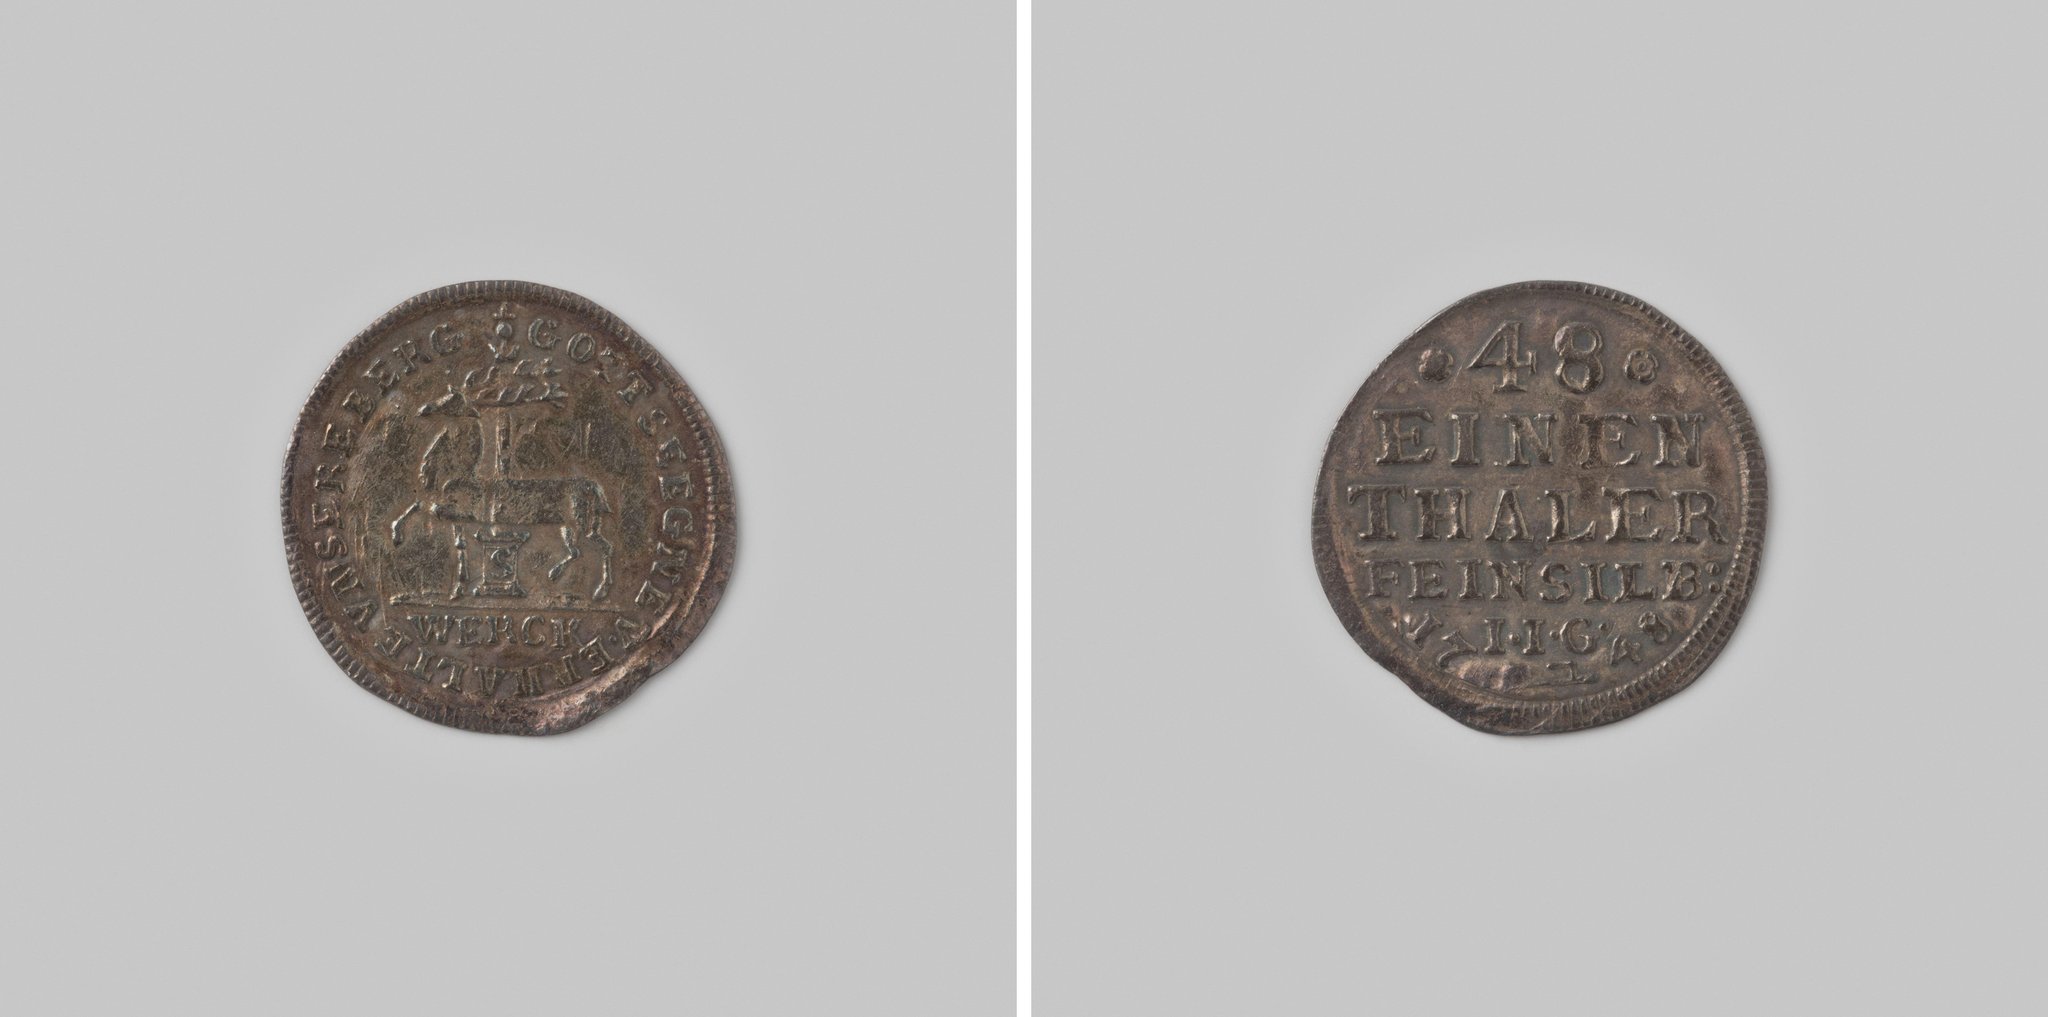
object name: coin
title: Graafschap Stolberg, Christoph Ludwig II en Friedrich Botho, sechser of ½ groschen, 1748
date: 1748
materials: silver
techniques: striking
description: Zilveren munt. Voorzijde: springend hert naar links voor zuil op voet, waarin letter S. Keerzijde: waarde-aanduiding in vier regels. Daaronder in omschrift jaartal. Gladde rand.